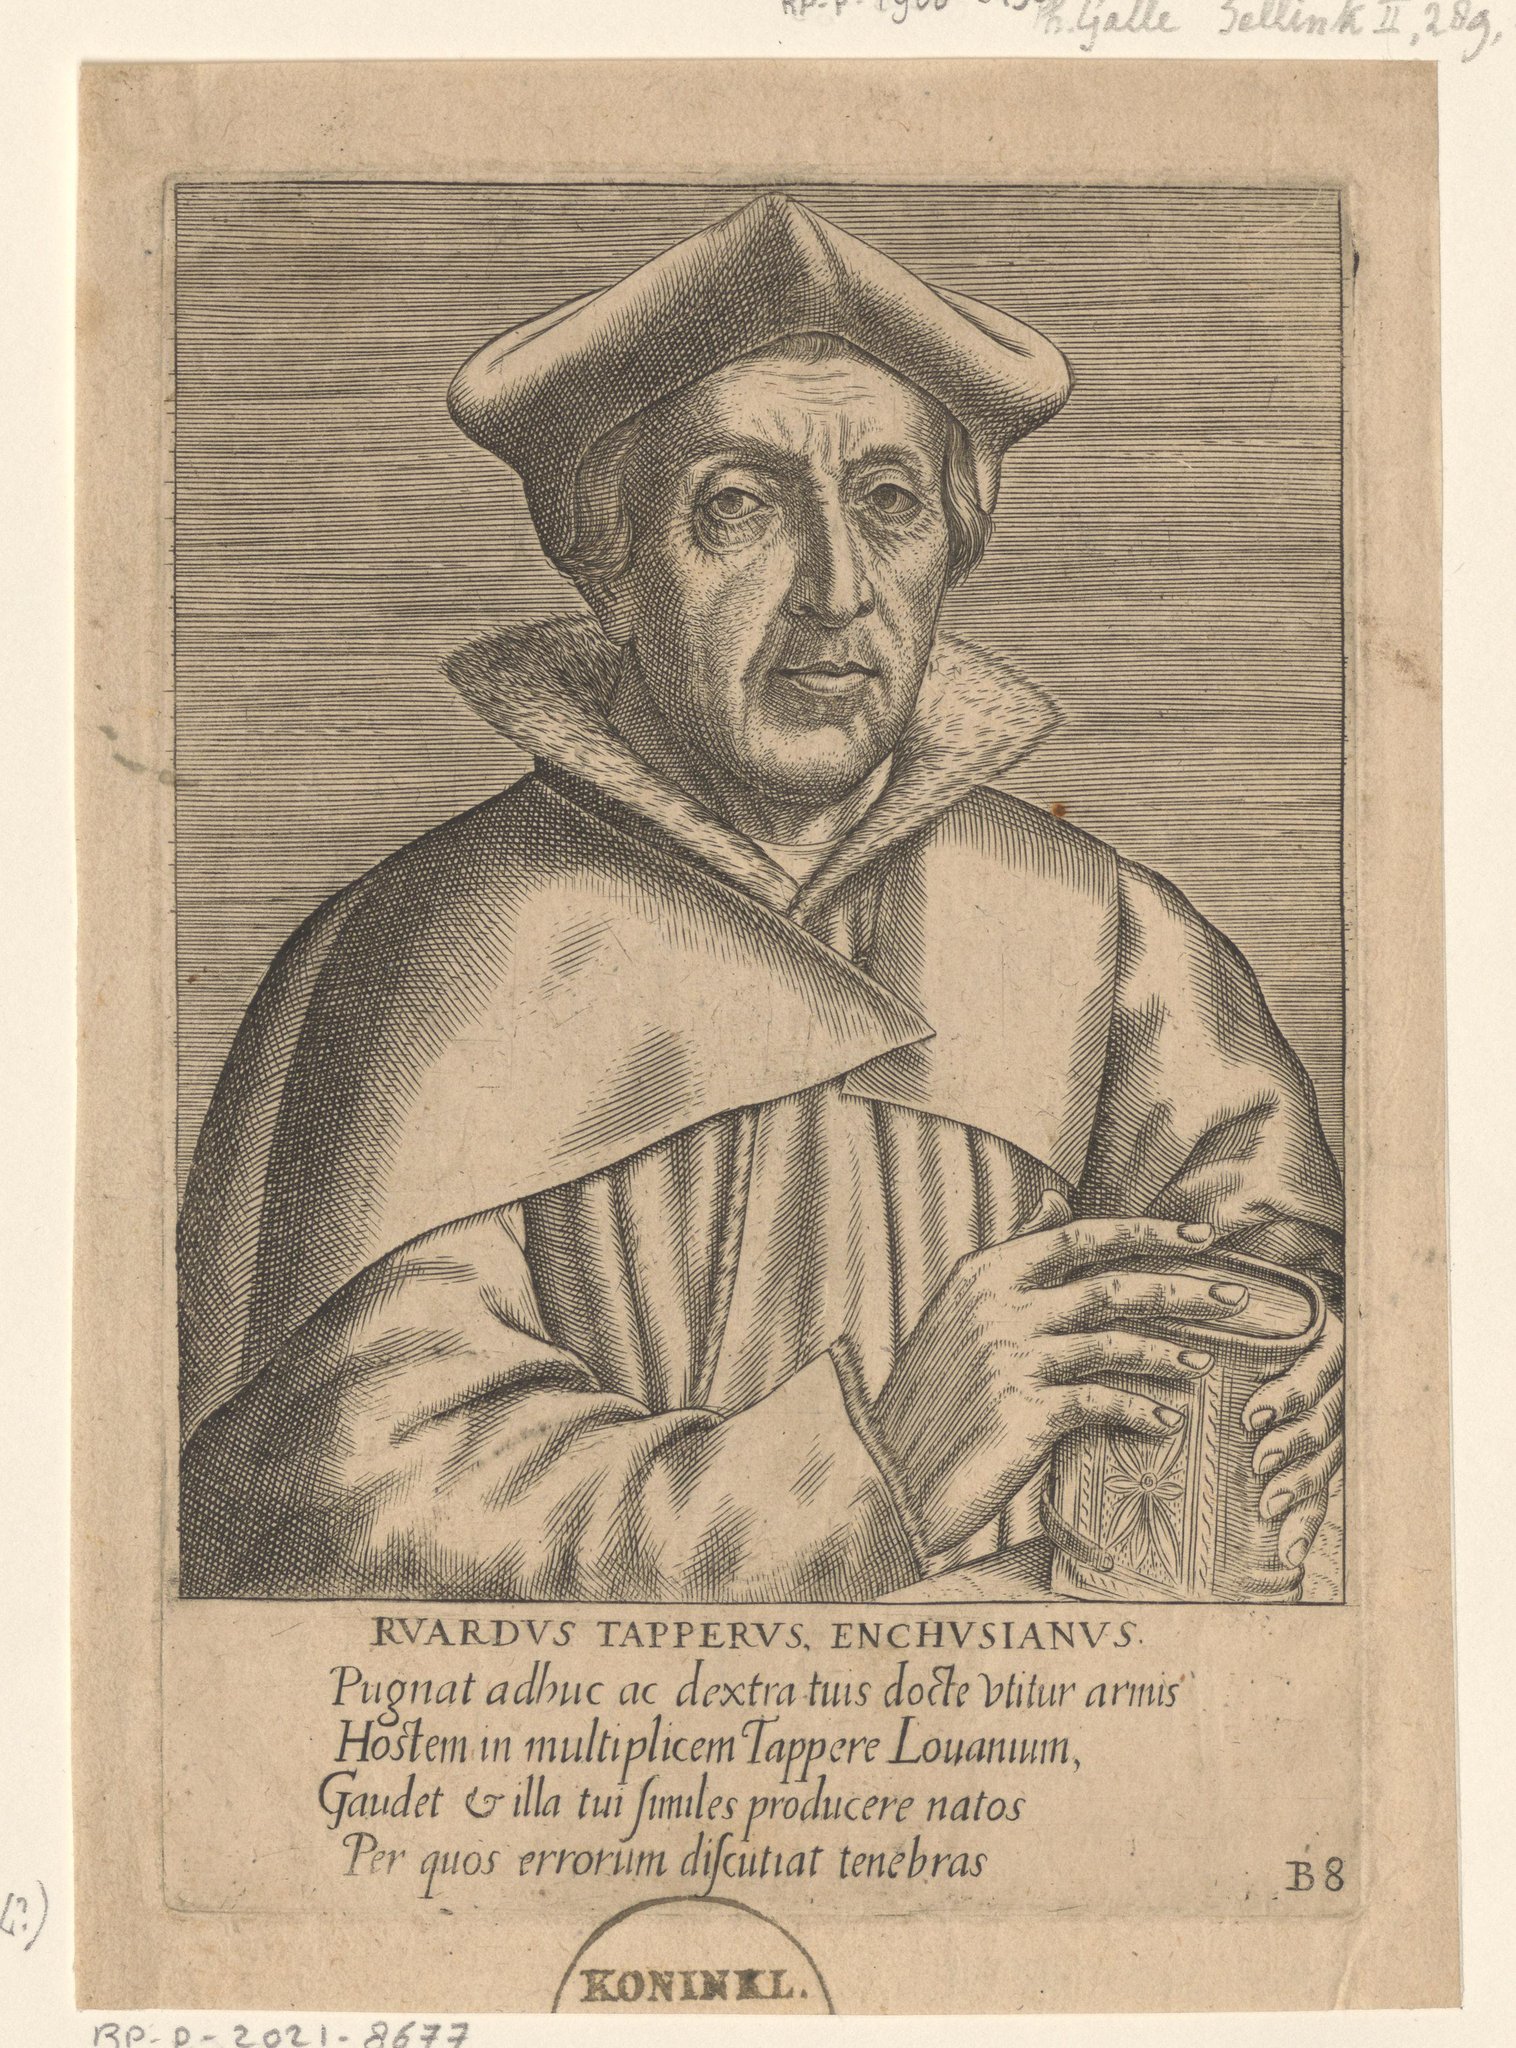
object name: print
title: Portretten van beroemde Europese geleerden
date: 1572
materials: paper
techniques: engraving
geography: antwerp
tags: enkhuizen, cardinal, historical persons, book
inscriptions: collector's mark: ‘Koninkl.’